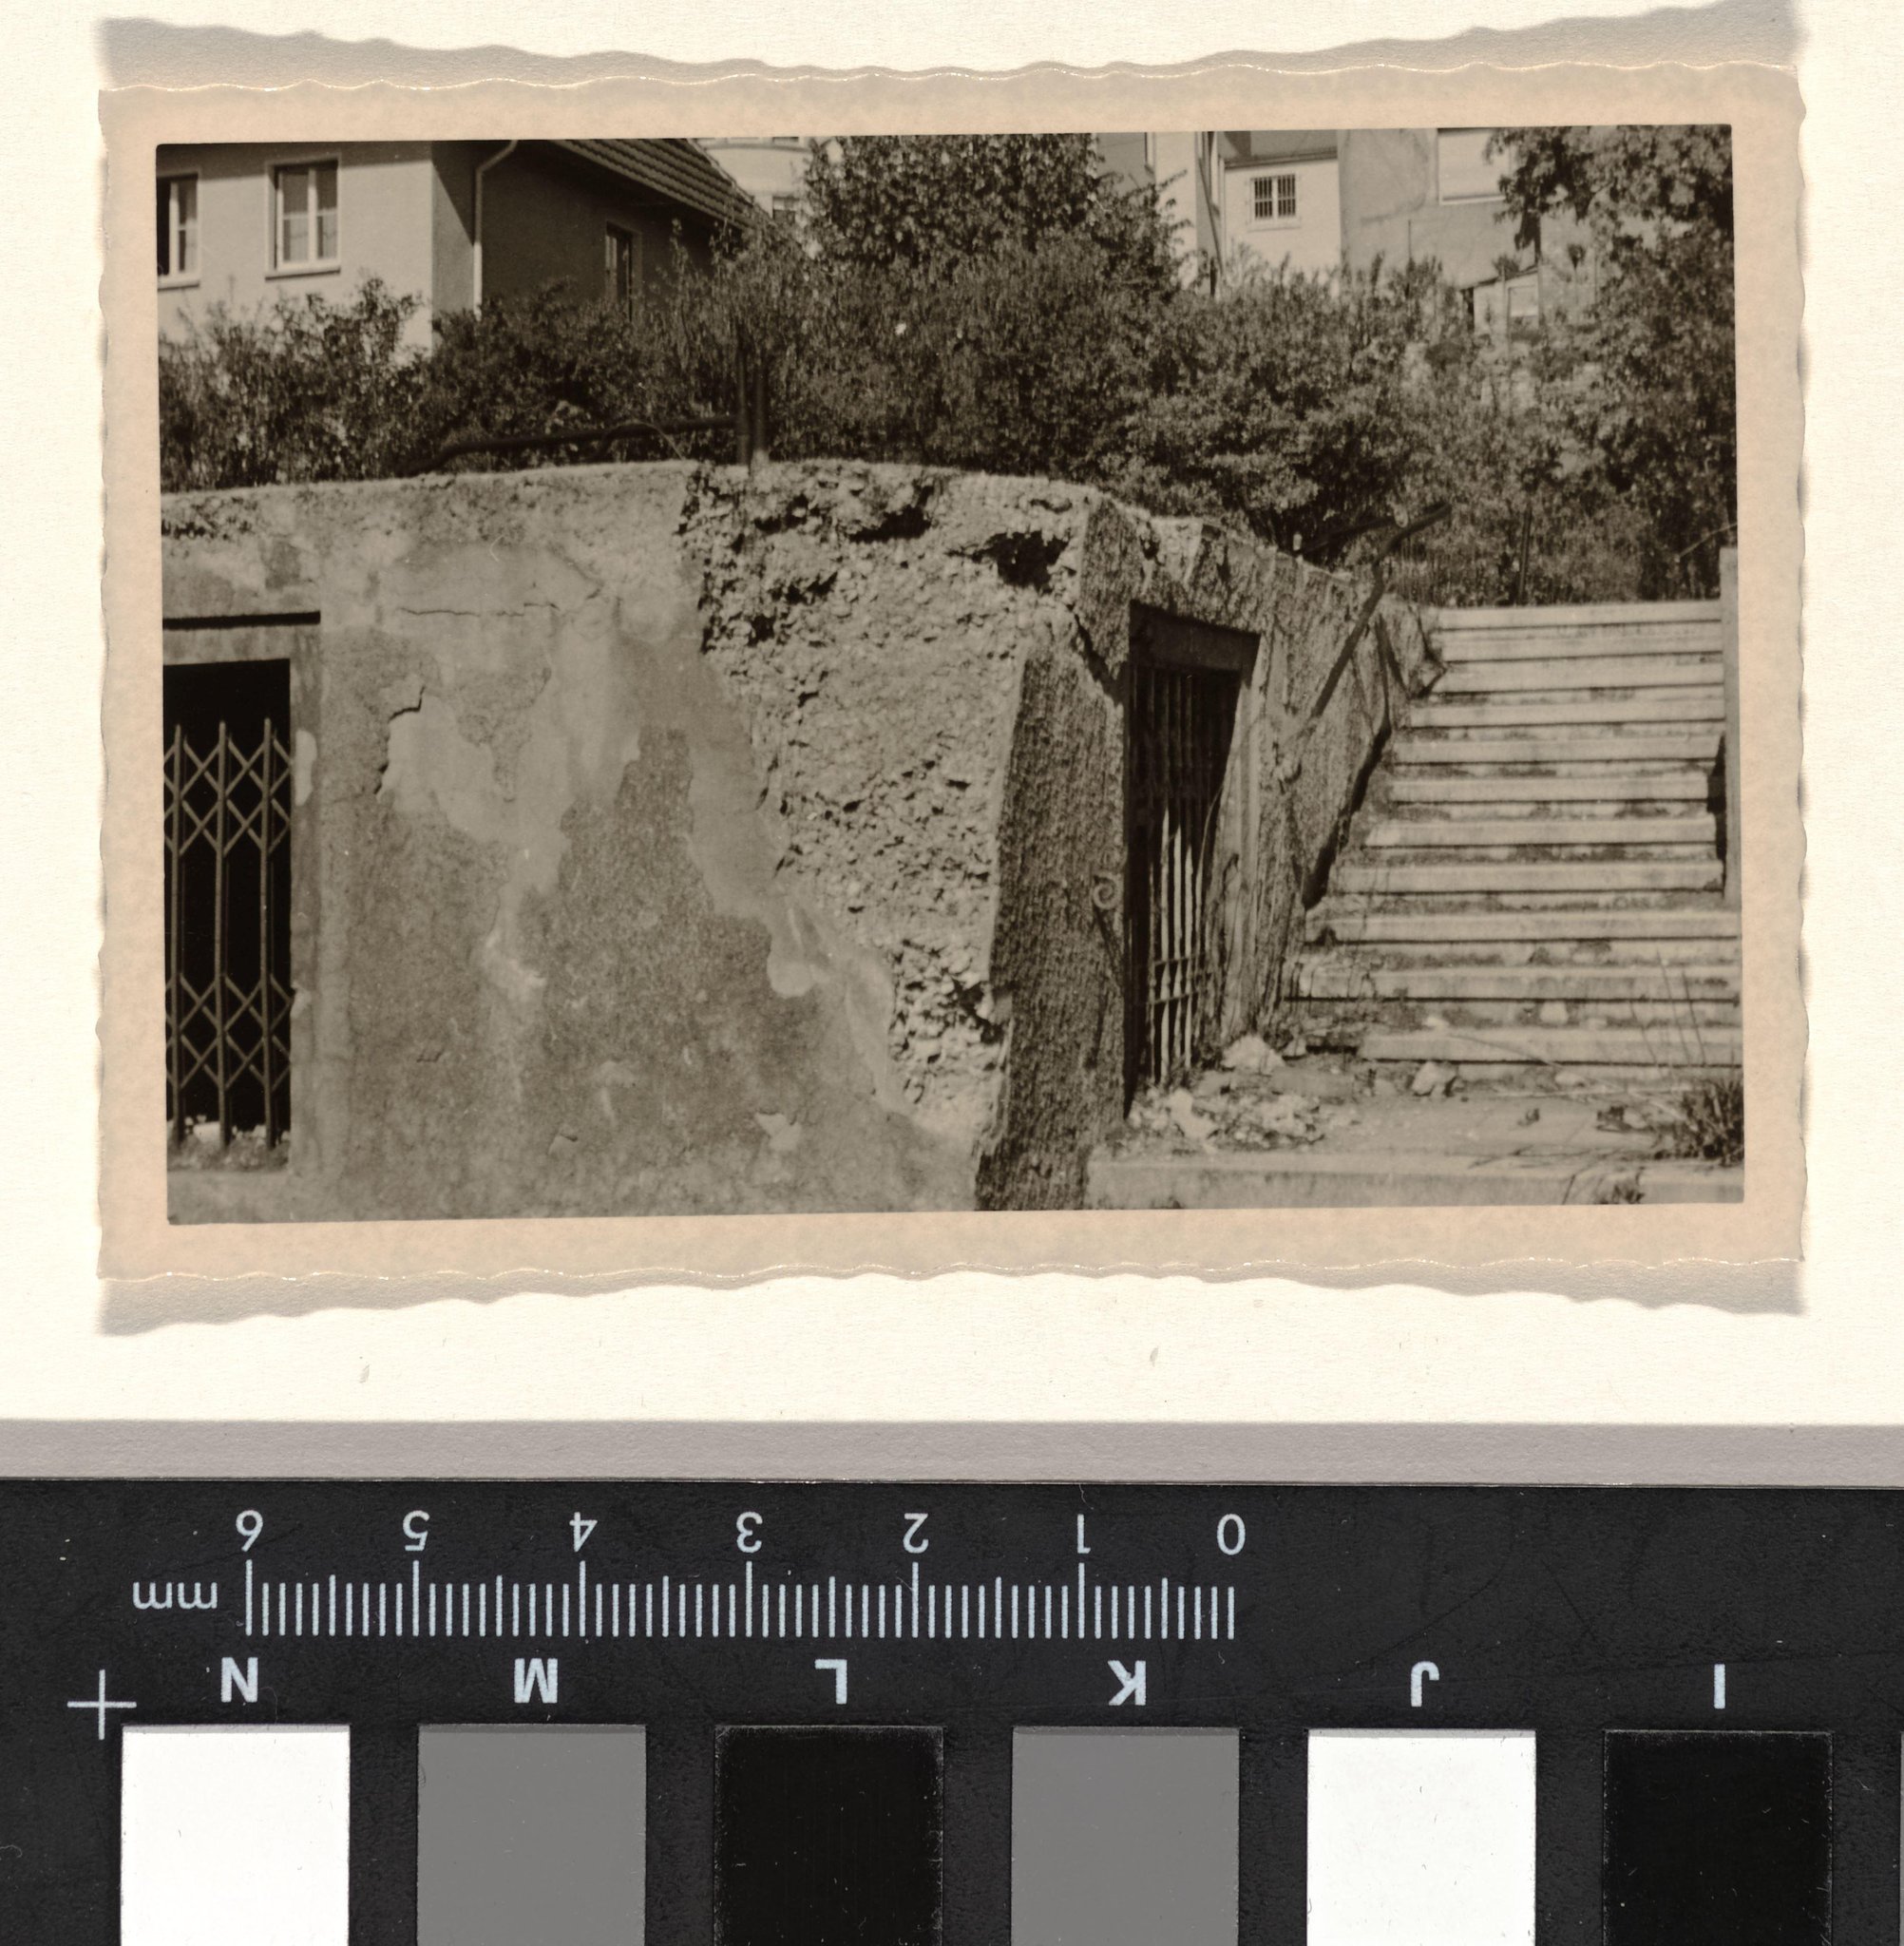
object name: photograph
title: Deel van een ruïne met een schuifhek en een deurgat daarin, met een groot huis met balkon op de achtergrond, met boom en struiken daar omheen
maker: Anonymous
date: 1945-1970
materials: photographic support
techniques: gelatin silver print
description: Deel van een ruïne met een schuifhek en een deurgat daarin, met een groot huis met balkon op de achtergrond, met boom en struiken daar omheen.